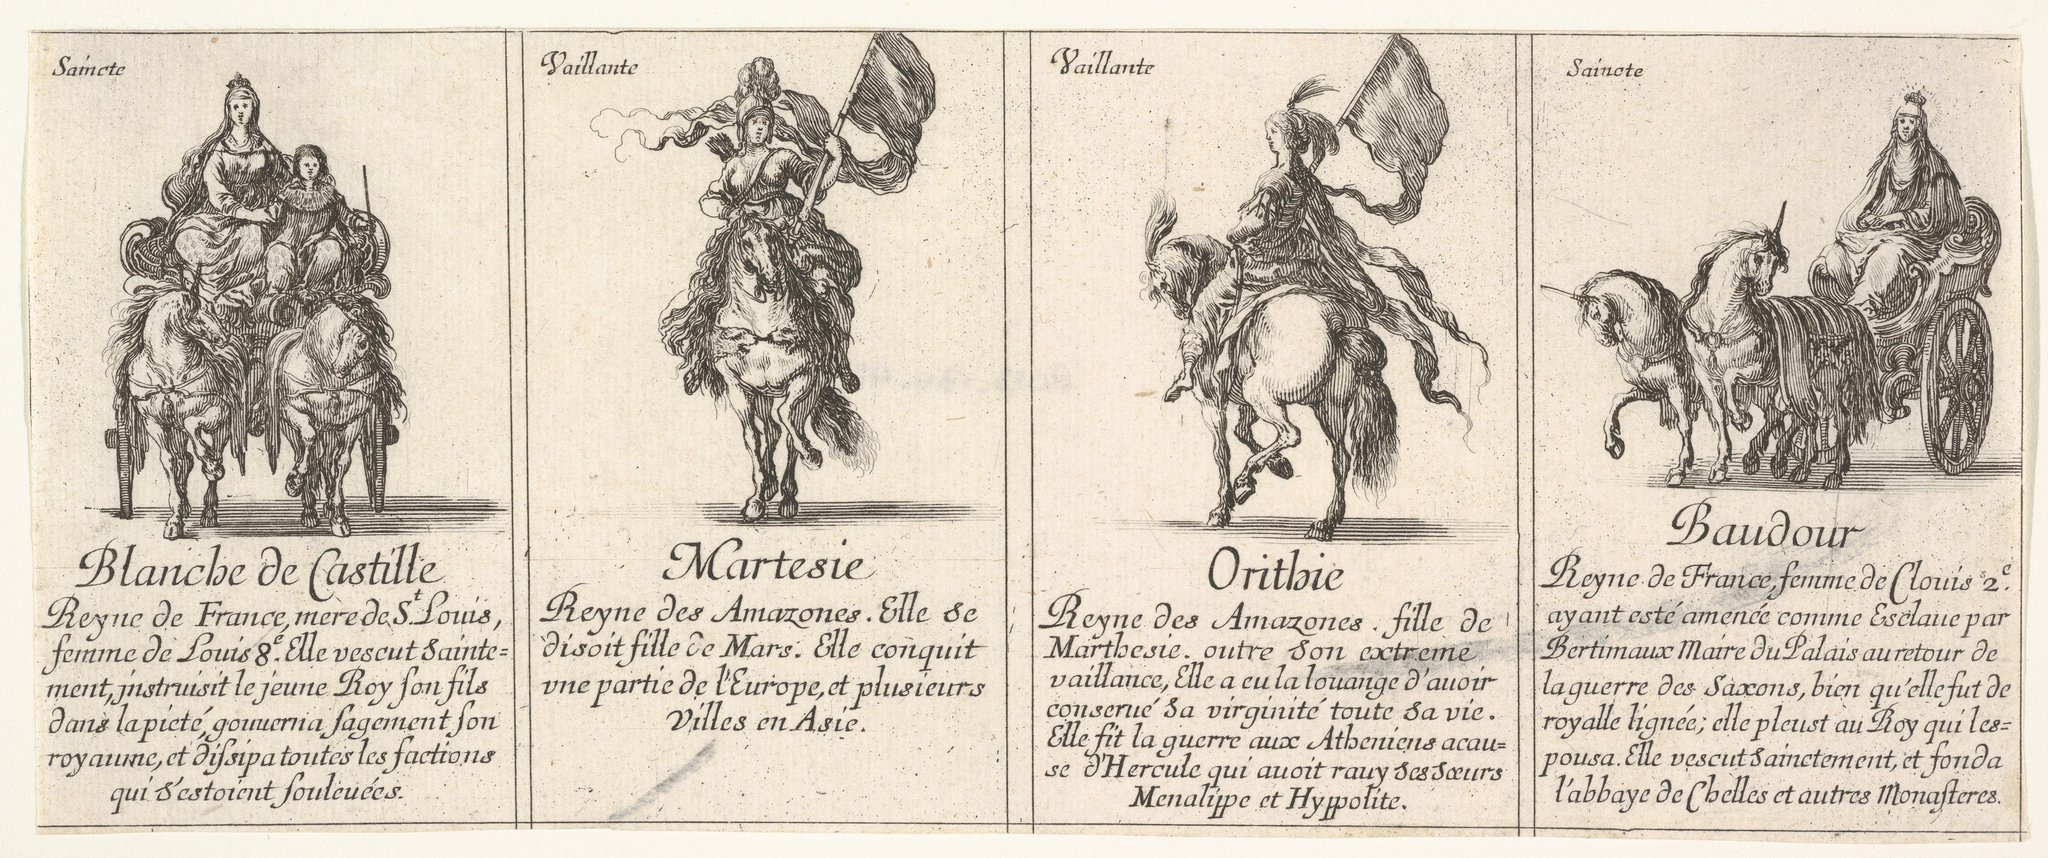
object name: print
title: Blanche de Castille, Martesie, Orithie, and Baudour, from "The Game of Queens" (Le Jeu des Reines Renommées)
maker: stefano della bella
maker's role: artist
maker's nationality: italian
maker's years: 1610-1664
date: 1644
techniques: etching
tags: women,unicorns,horses,chariots